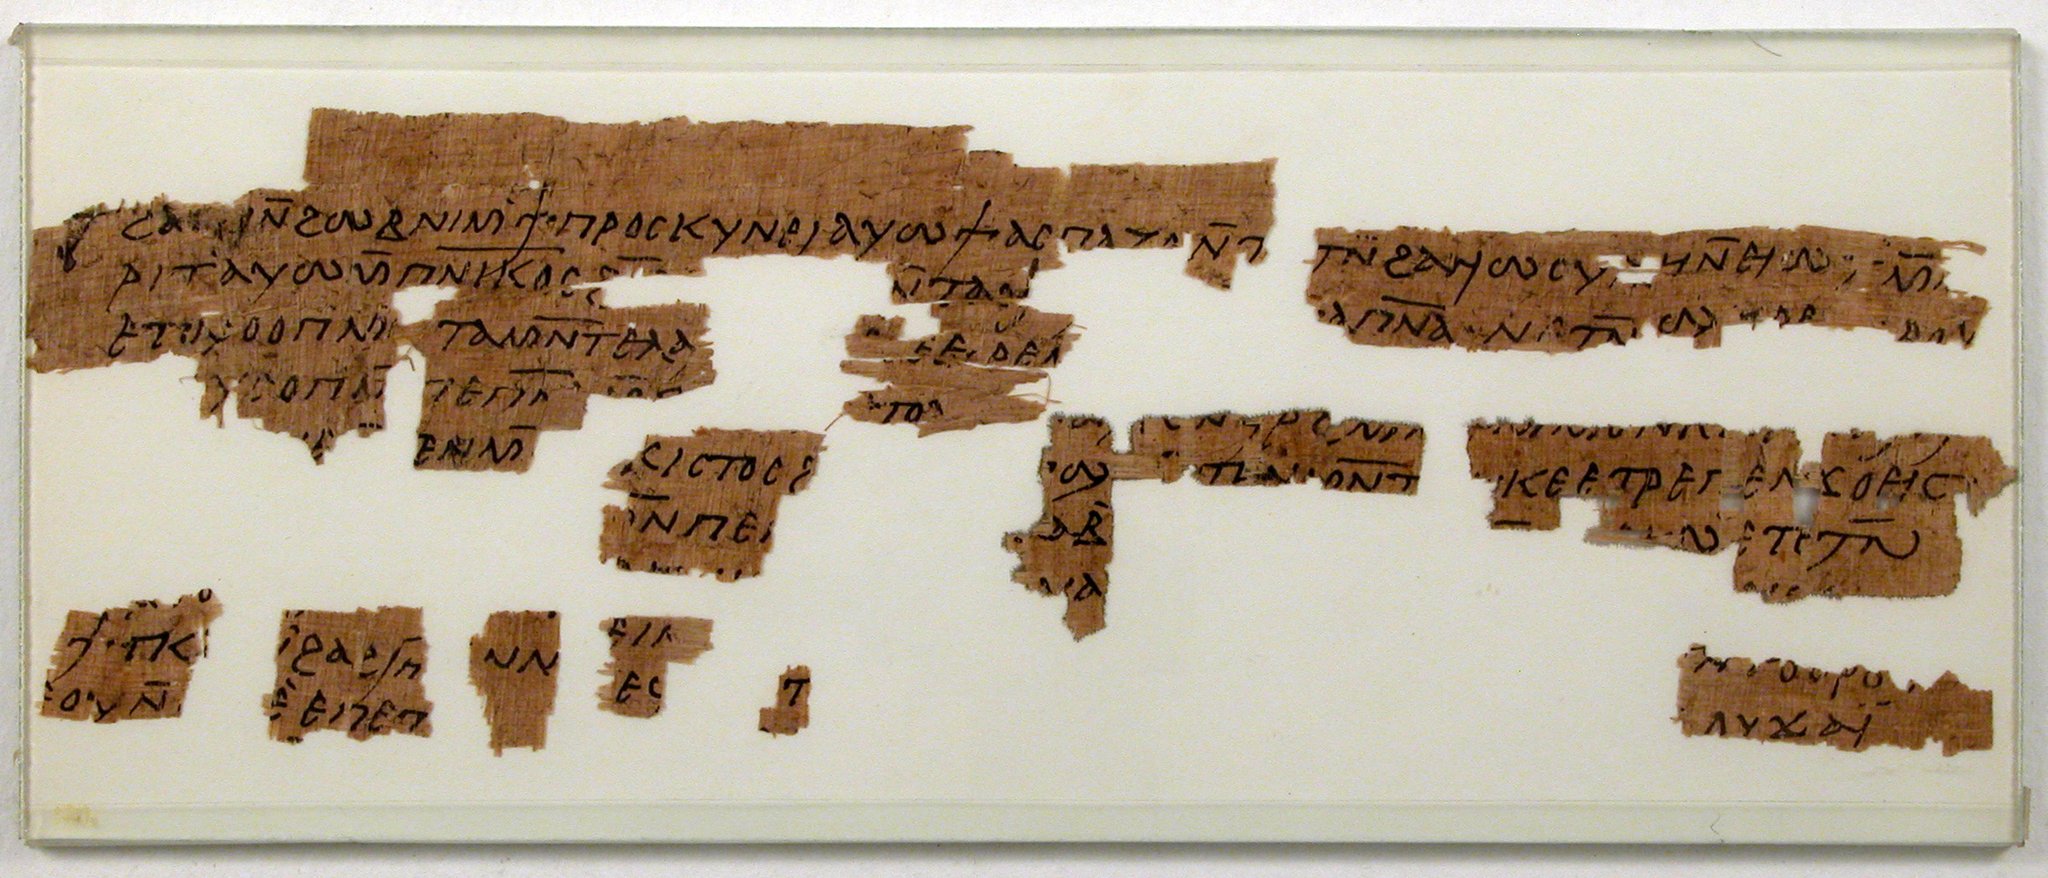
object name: fragment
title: Papyri Fragments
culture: coptic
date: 601-700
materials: ink, papyrus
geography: egypt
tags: coptic,documents